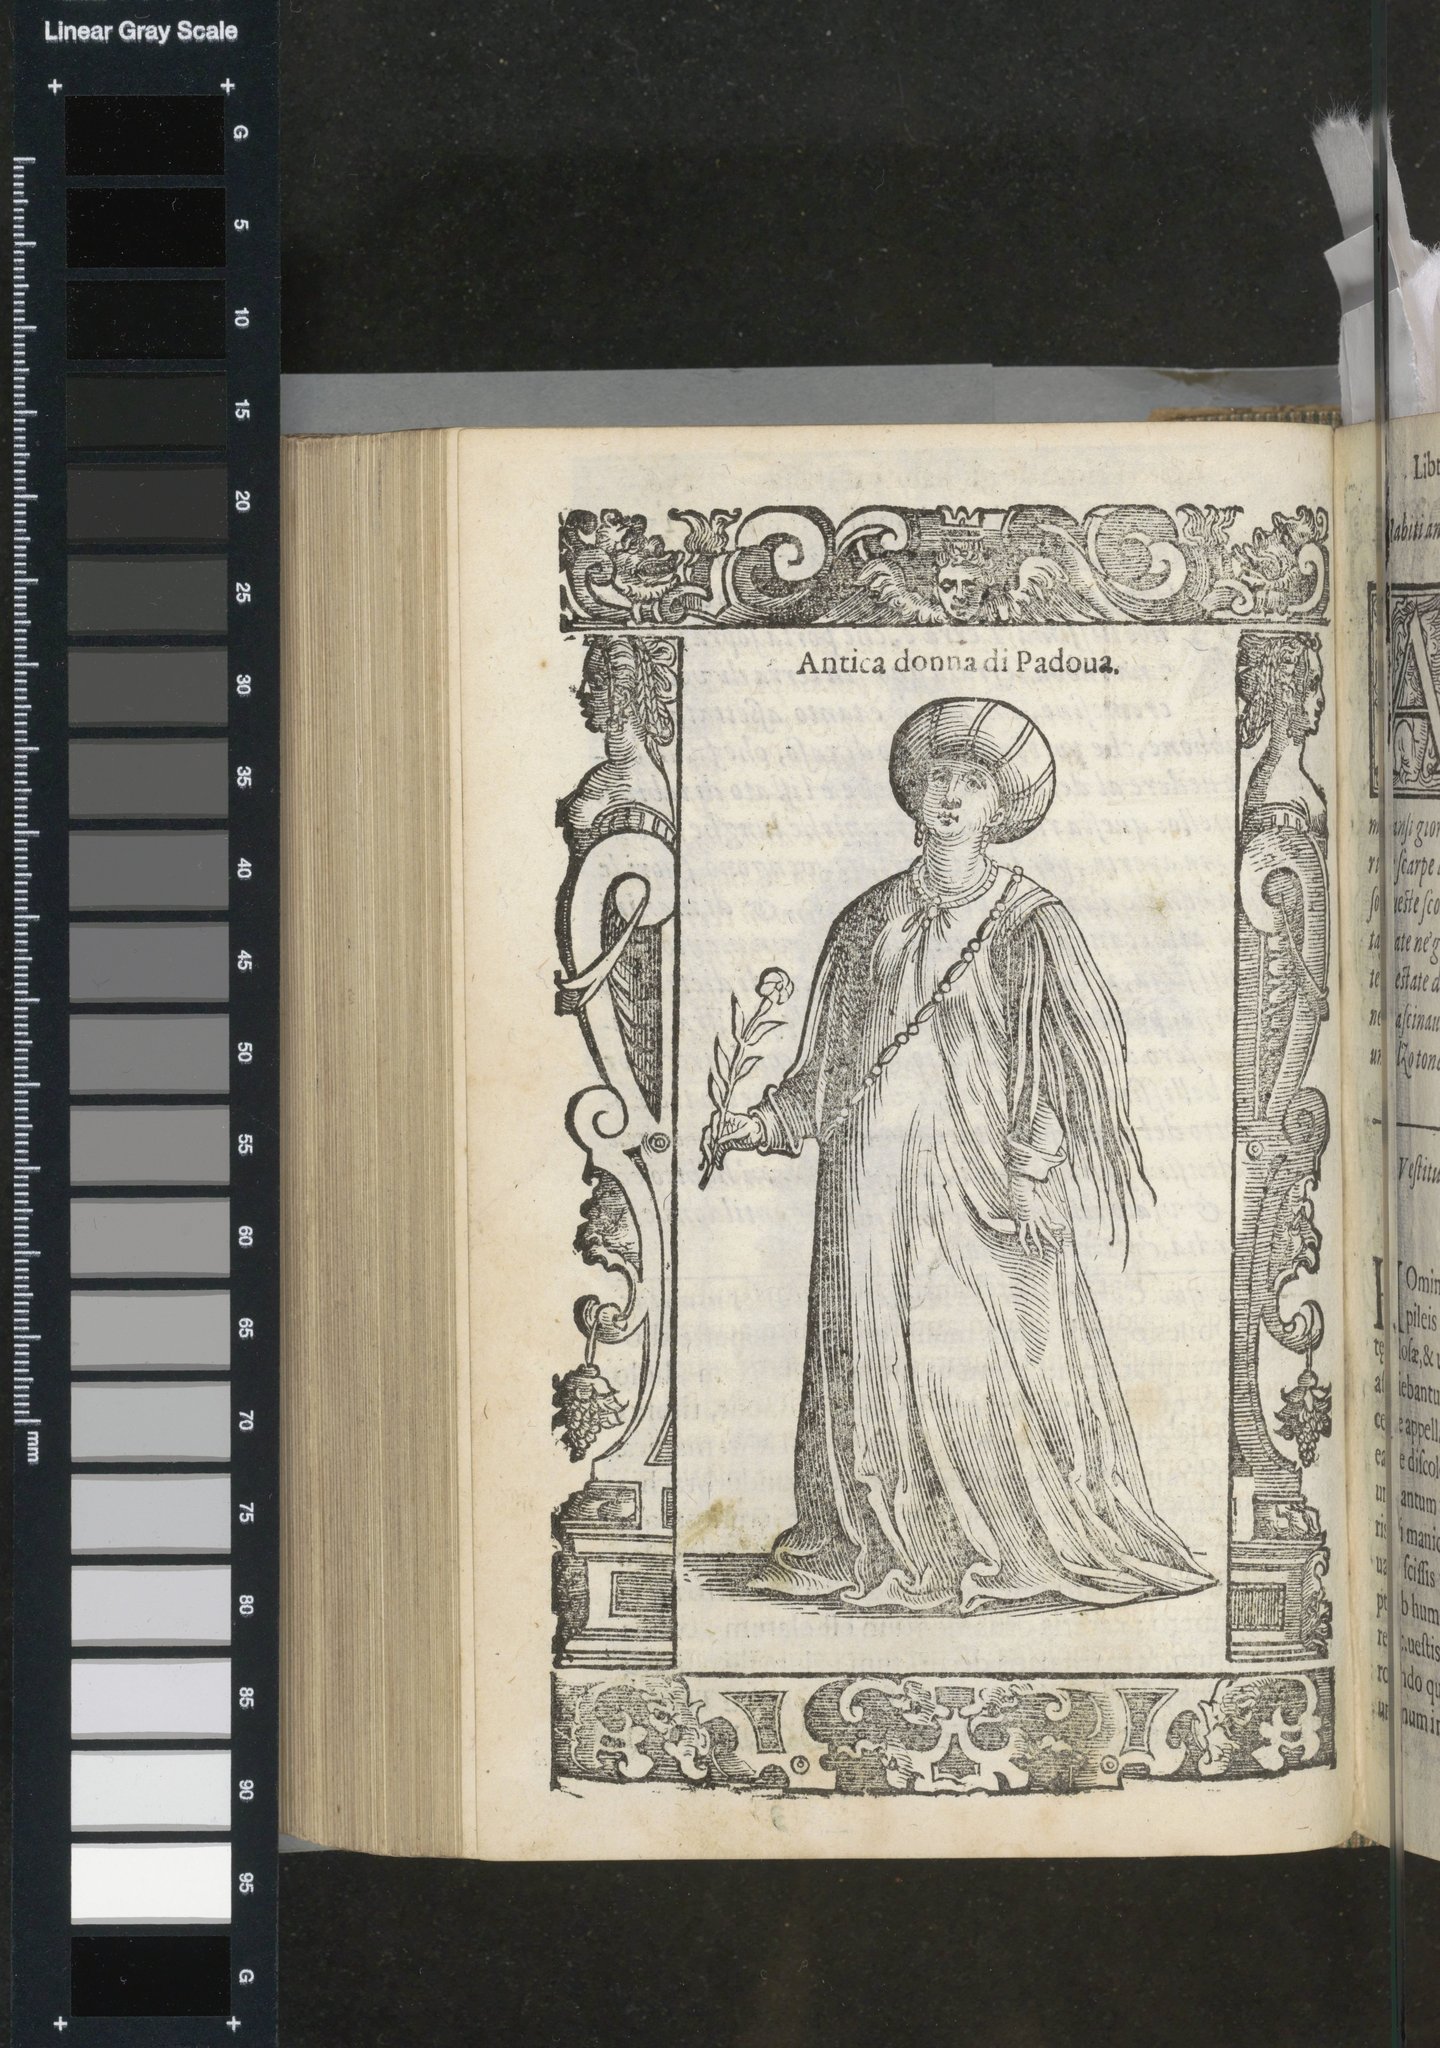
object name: costume print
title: Antica donna di padova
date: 1598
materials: paper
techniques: woodcut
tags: fashion plates